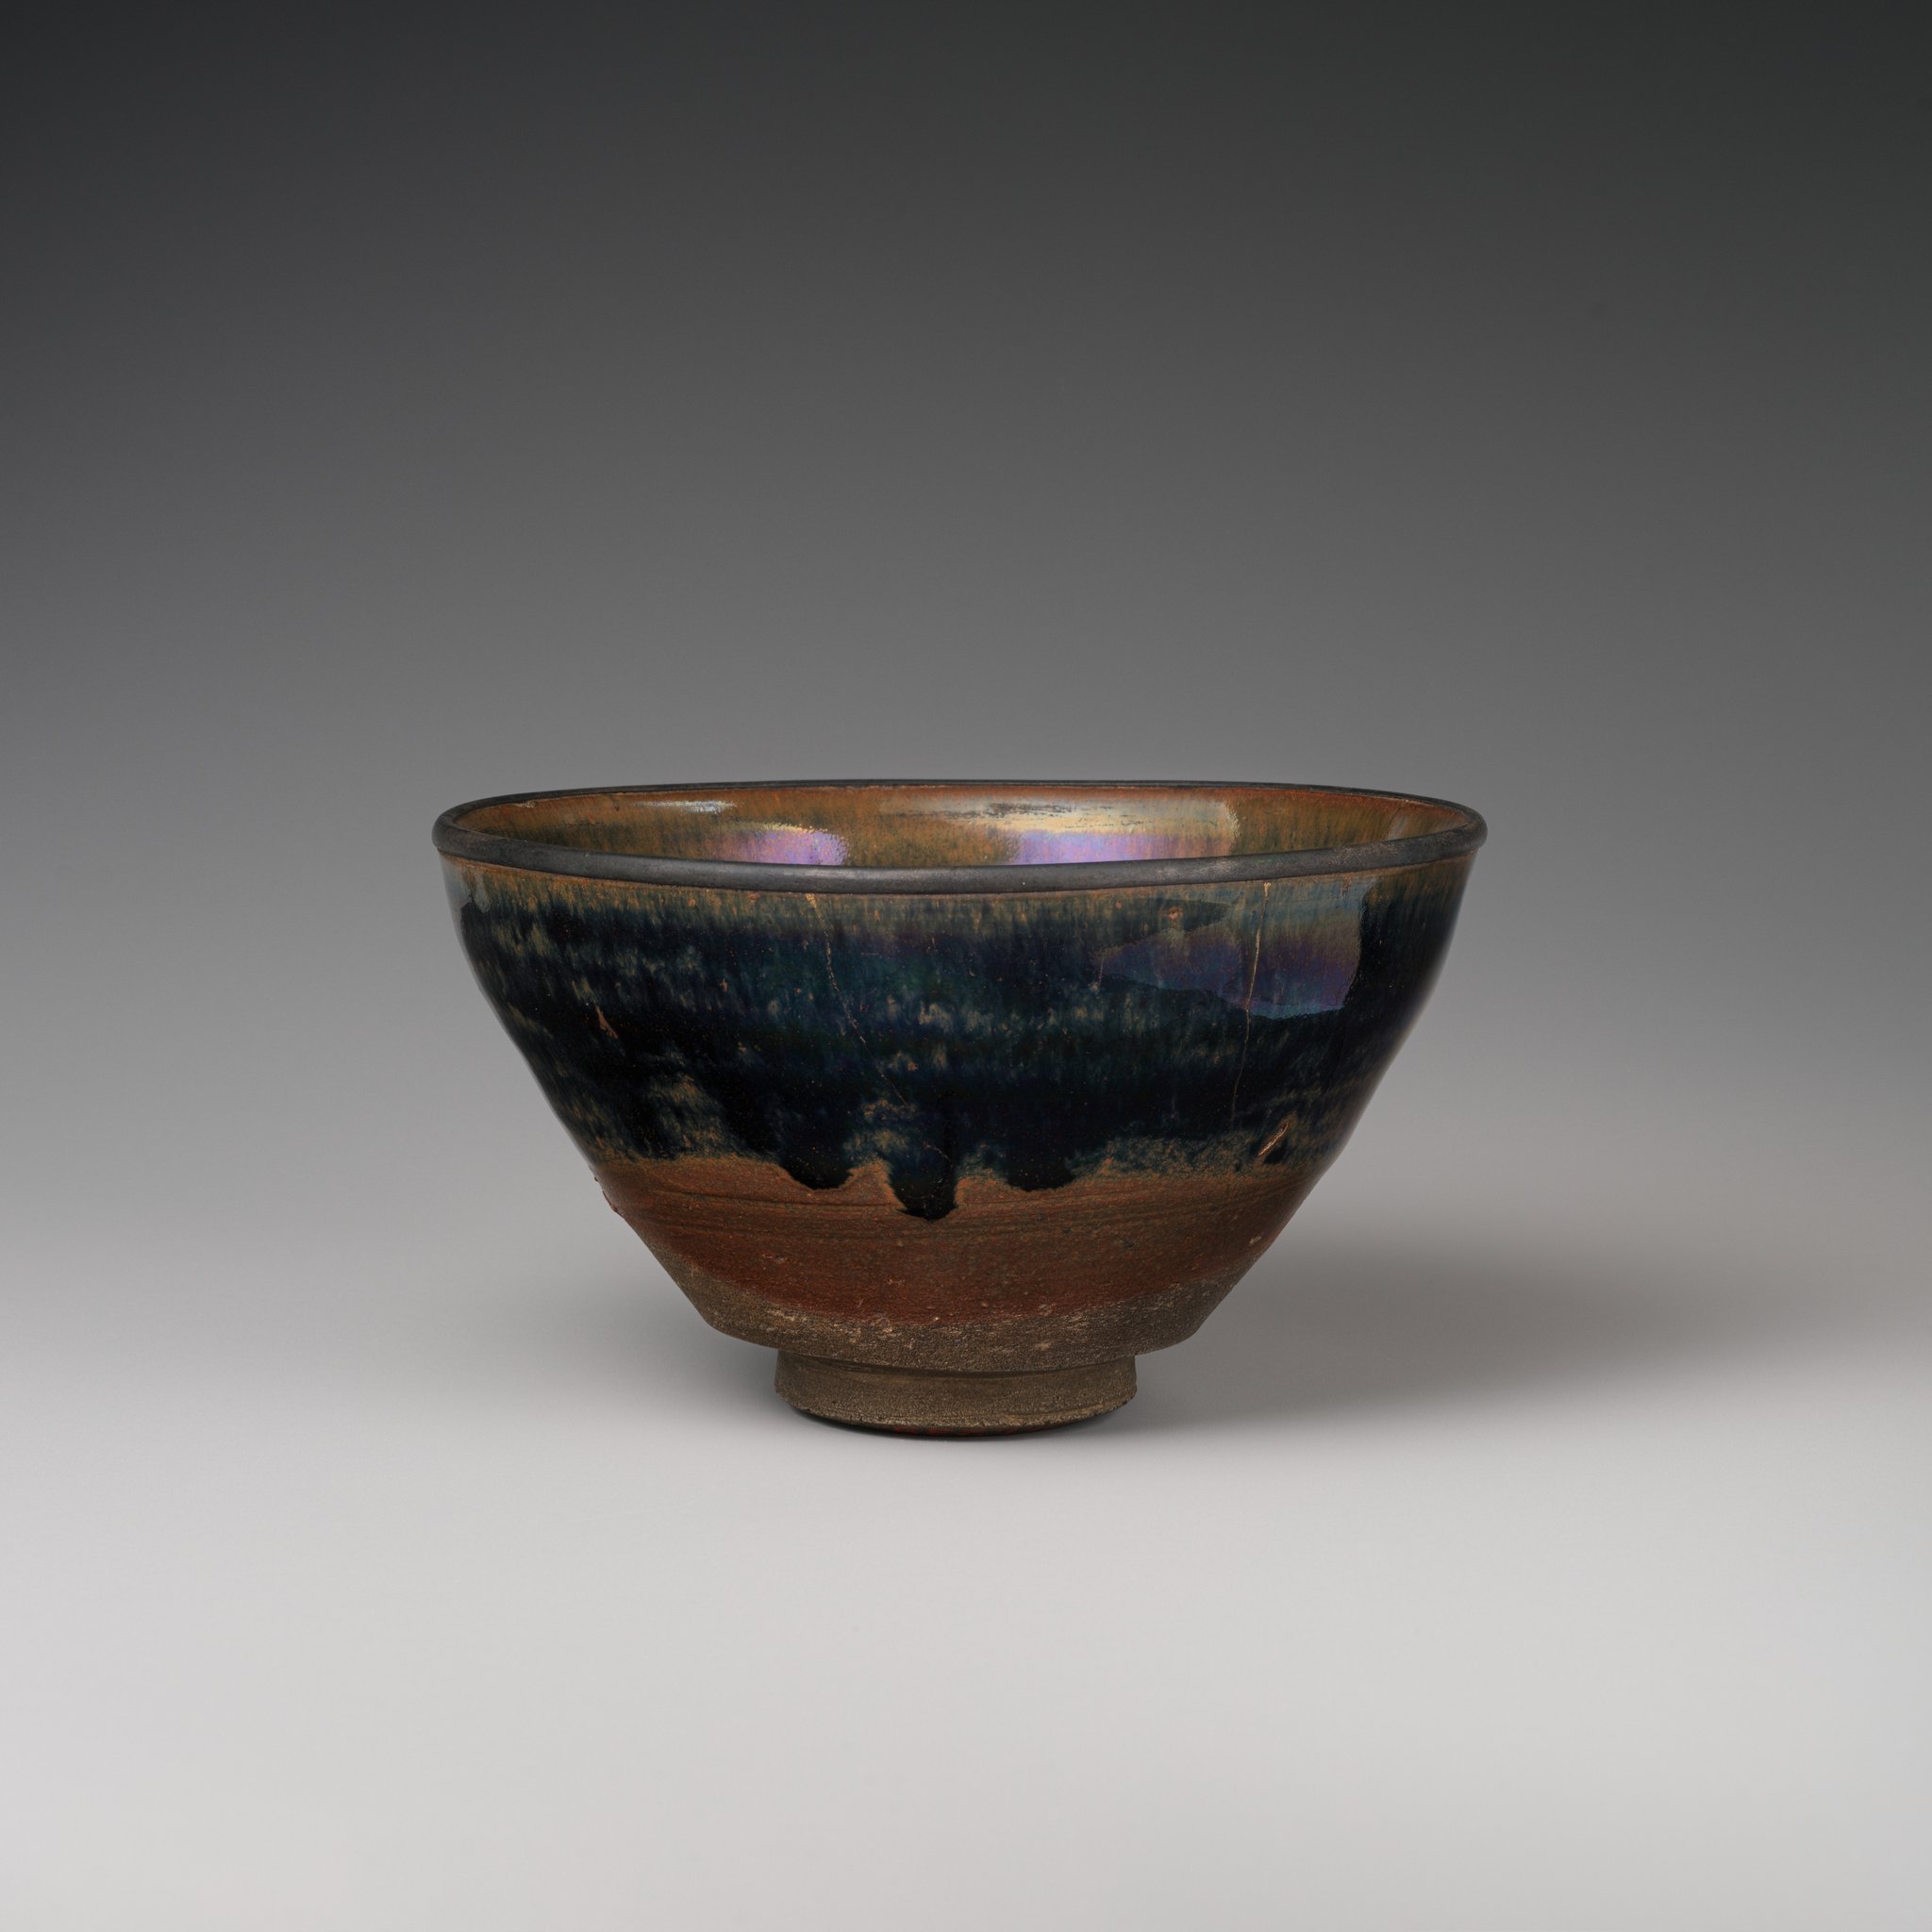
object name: teabowl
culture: japanese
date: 1801-1900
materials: clay, glaze